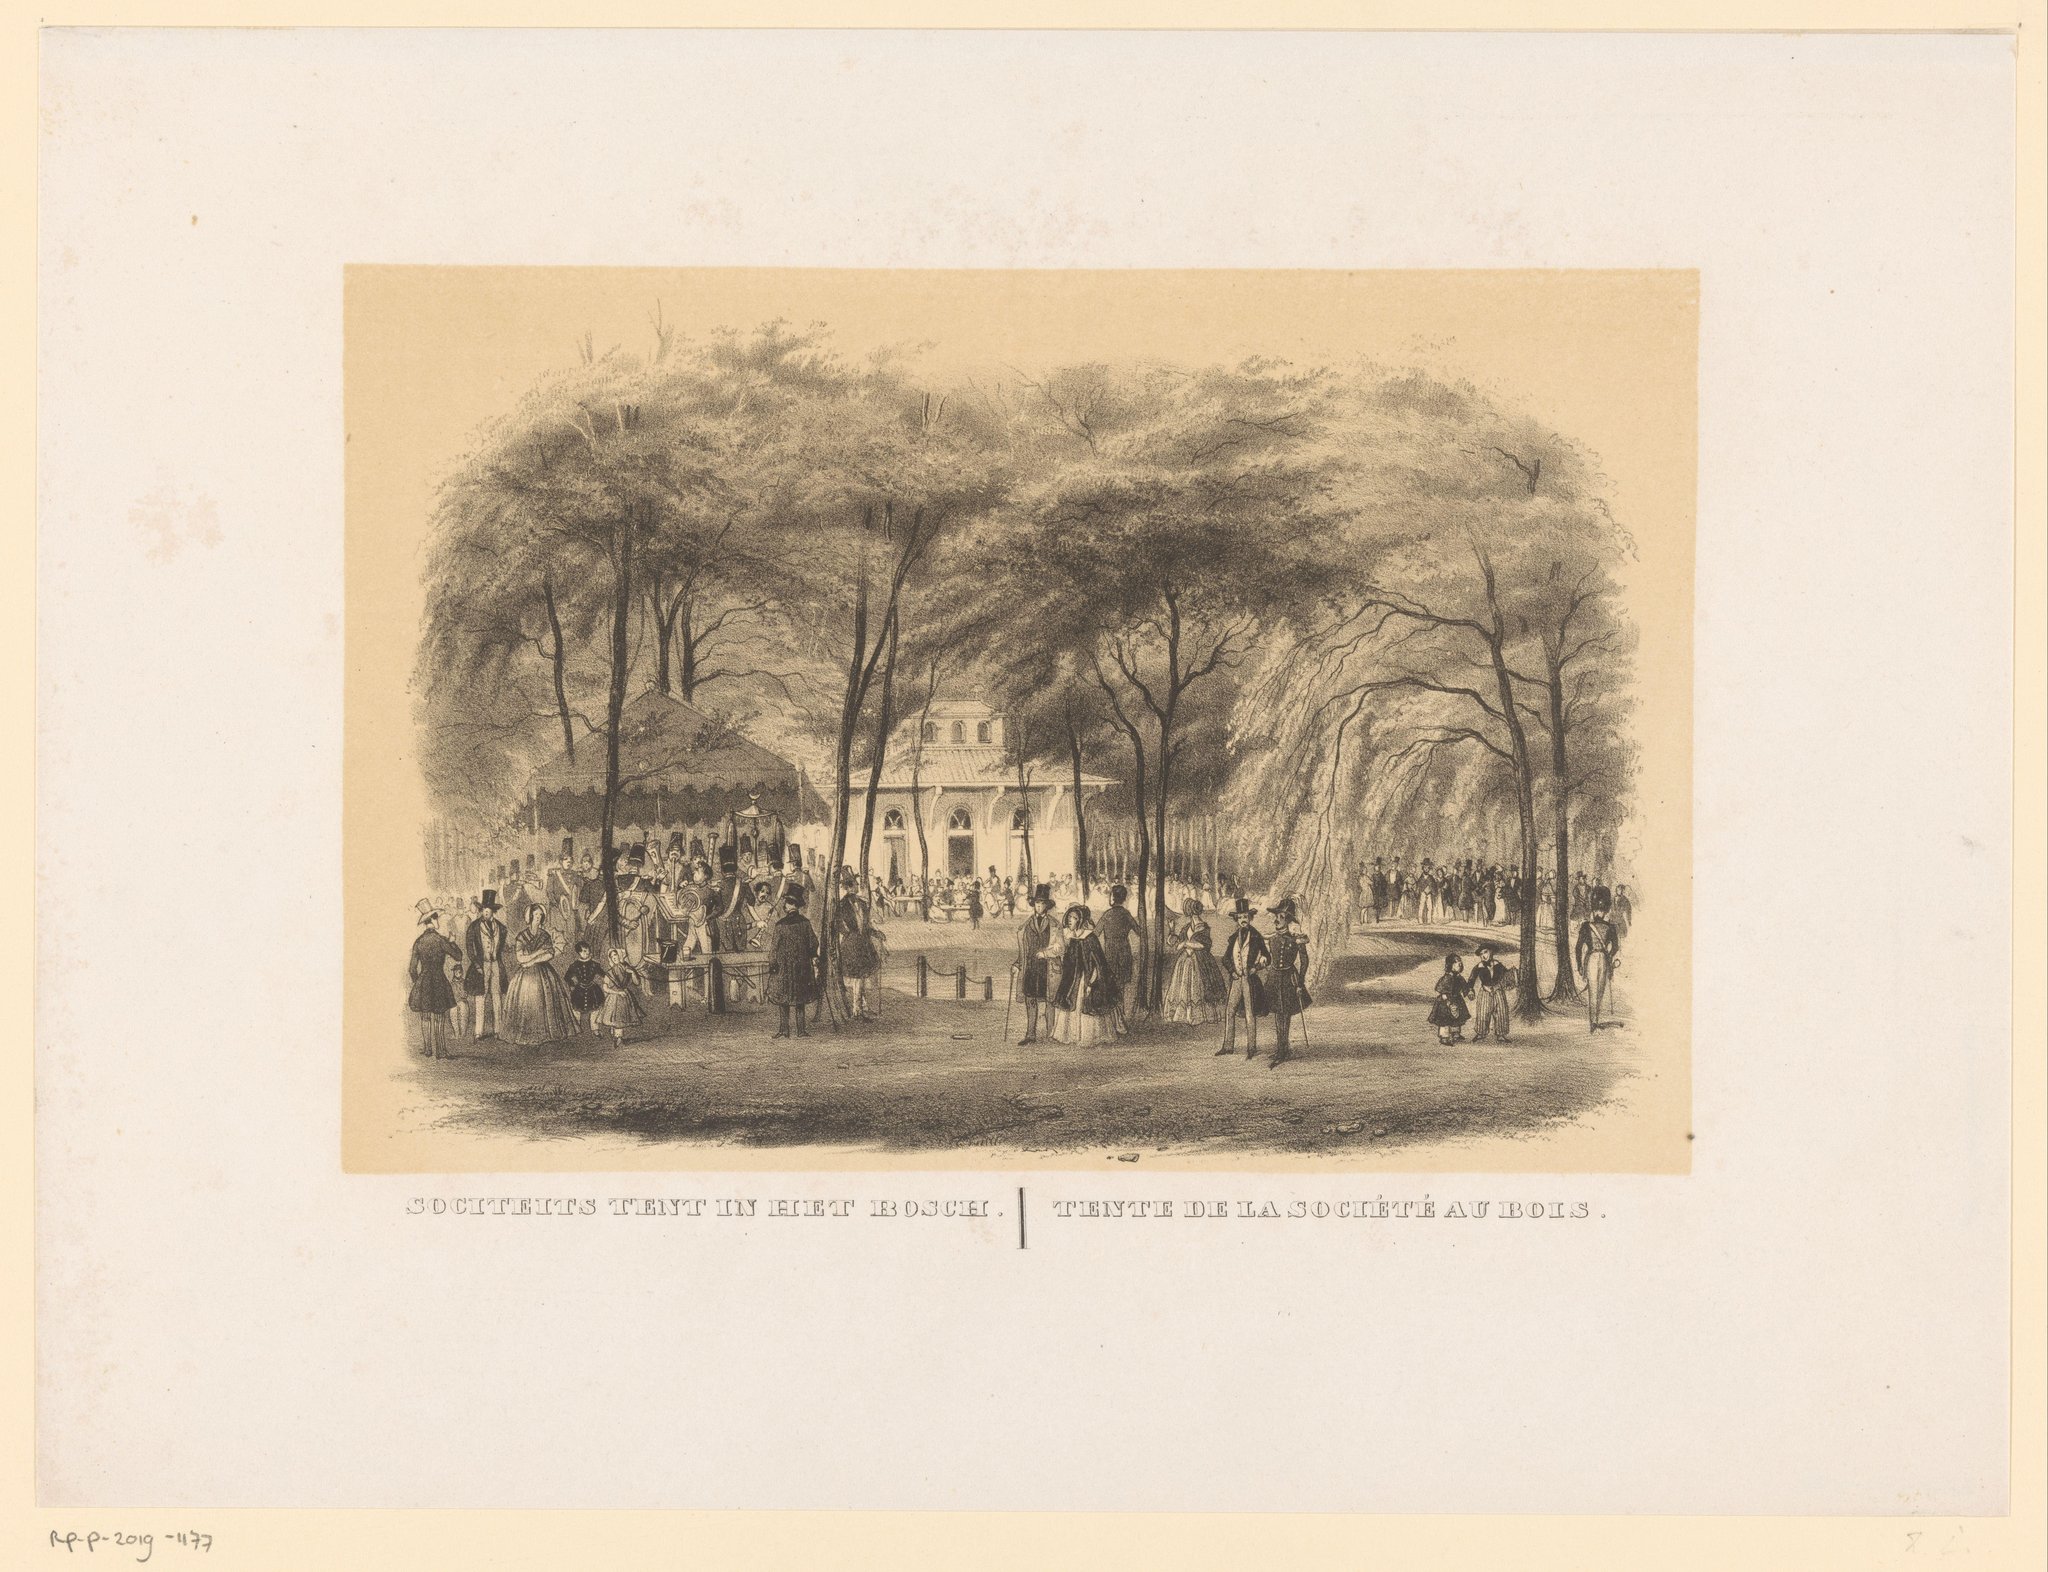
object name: print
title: Socitiets tent in het Bosch / Tente de la Société au Bois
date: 1844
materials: paper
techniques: tone lithography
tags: brass band, street band, wood and park (as places of recreation), the hague